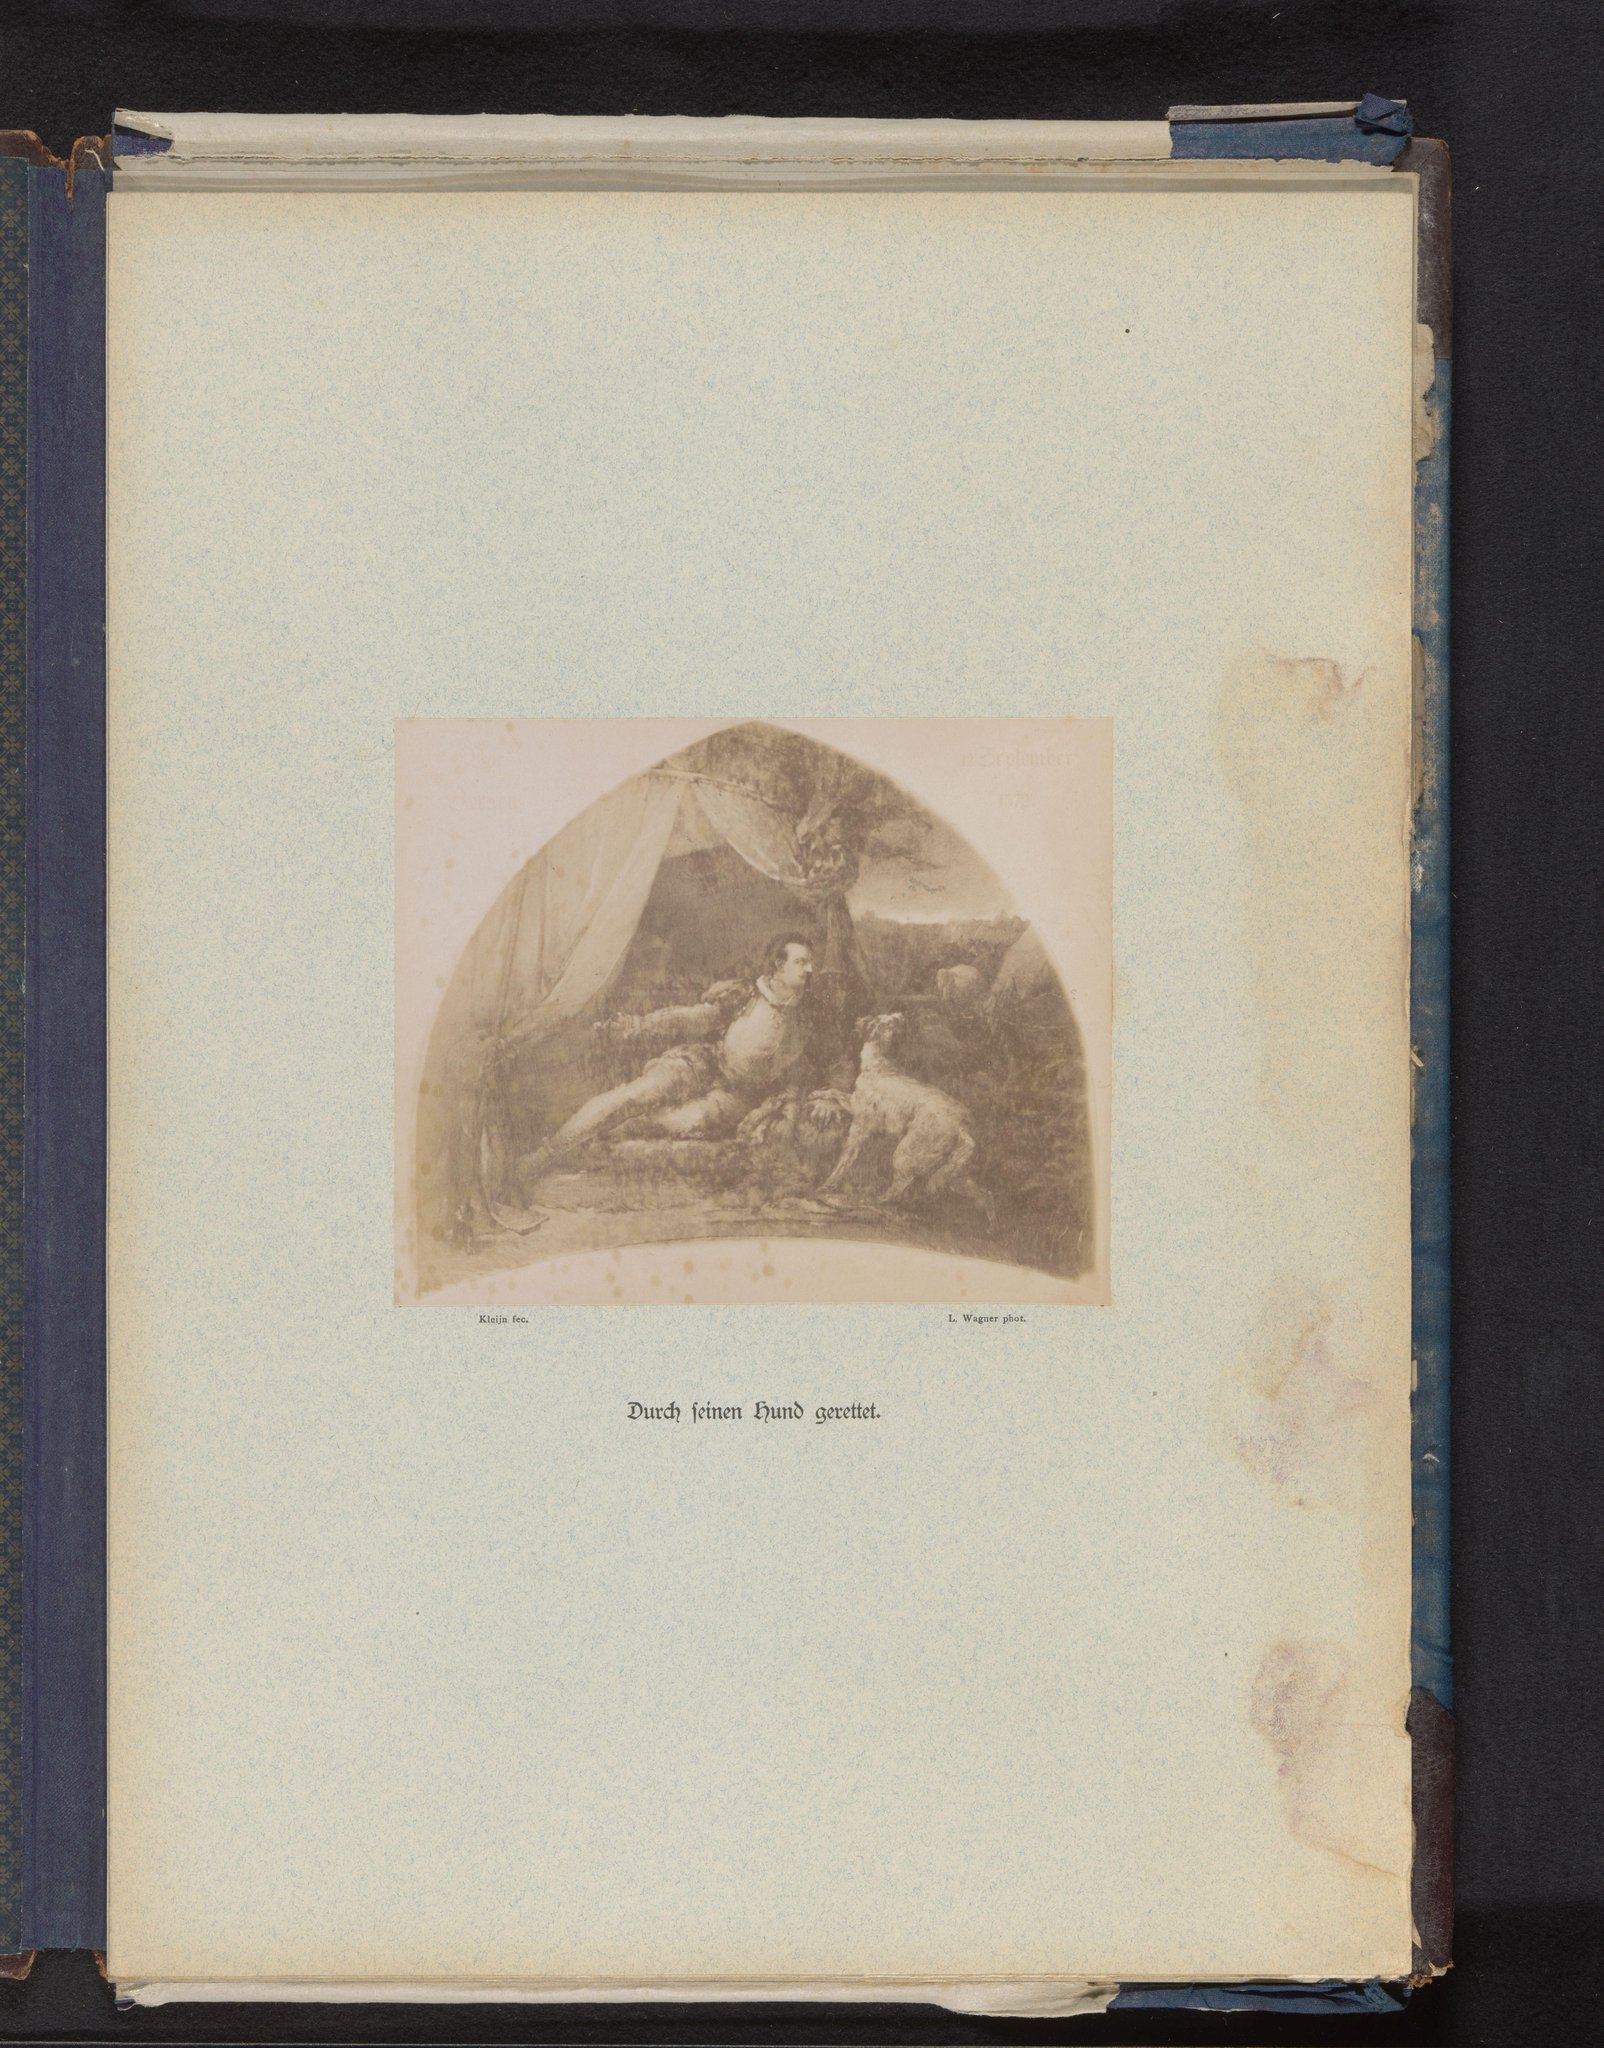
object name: reproduction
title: Durch seinen Hund gerettet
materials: photographic support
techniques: albumen print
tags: delft, william i (prince of orange), adult man, dog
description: Deze foto maakt deel uit van een omslag met acht foto's op acht bladen en twee tekstbladen.